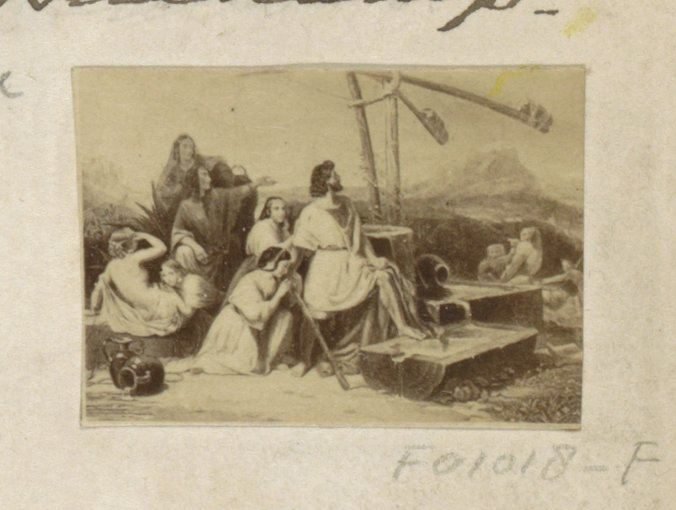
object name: photograph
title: Fotoreproductie van (vermoedelijk) een schilderij met een tafereel bij een put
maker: Anonymous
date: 1860-1870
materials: paper, photographic support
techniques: albumen print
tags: well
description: Onderdeel van Engels familiealbum met foto's van personen, reizen, cricket en kunstwerken.